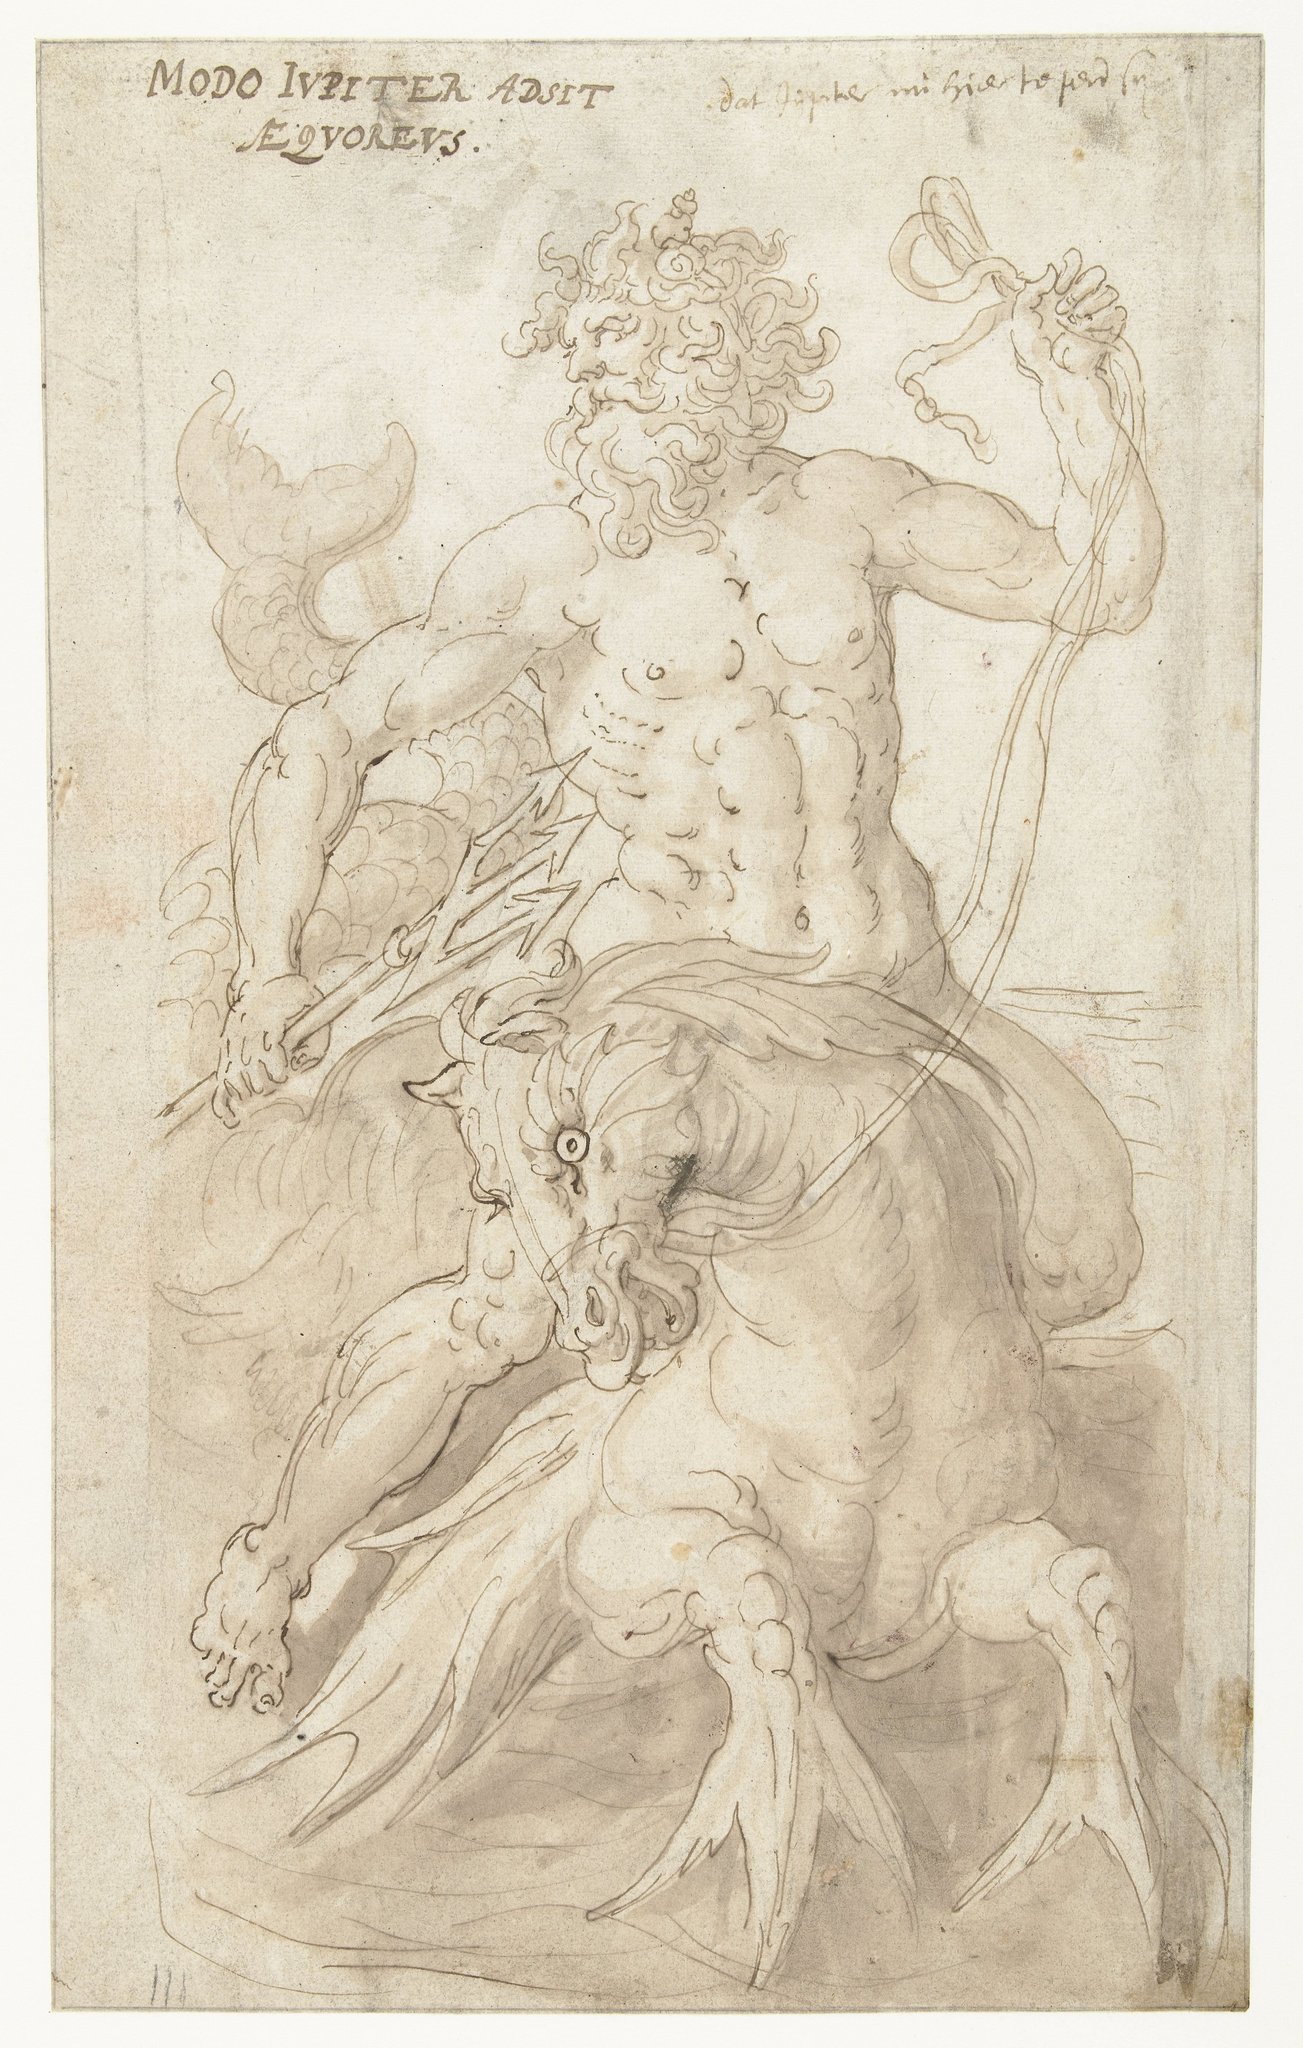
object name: drawing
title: Neptunus (?)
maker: Anonymous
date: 1594-1625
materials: ink, paper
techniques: brush, pen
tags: (story of) neptune (poseidon)